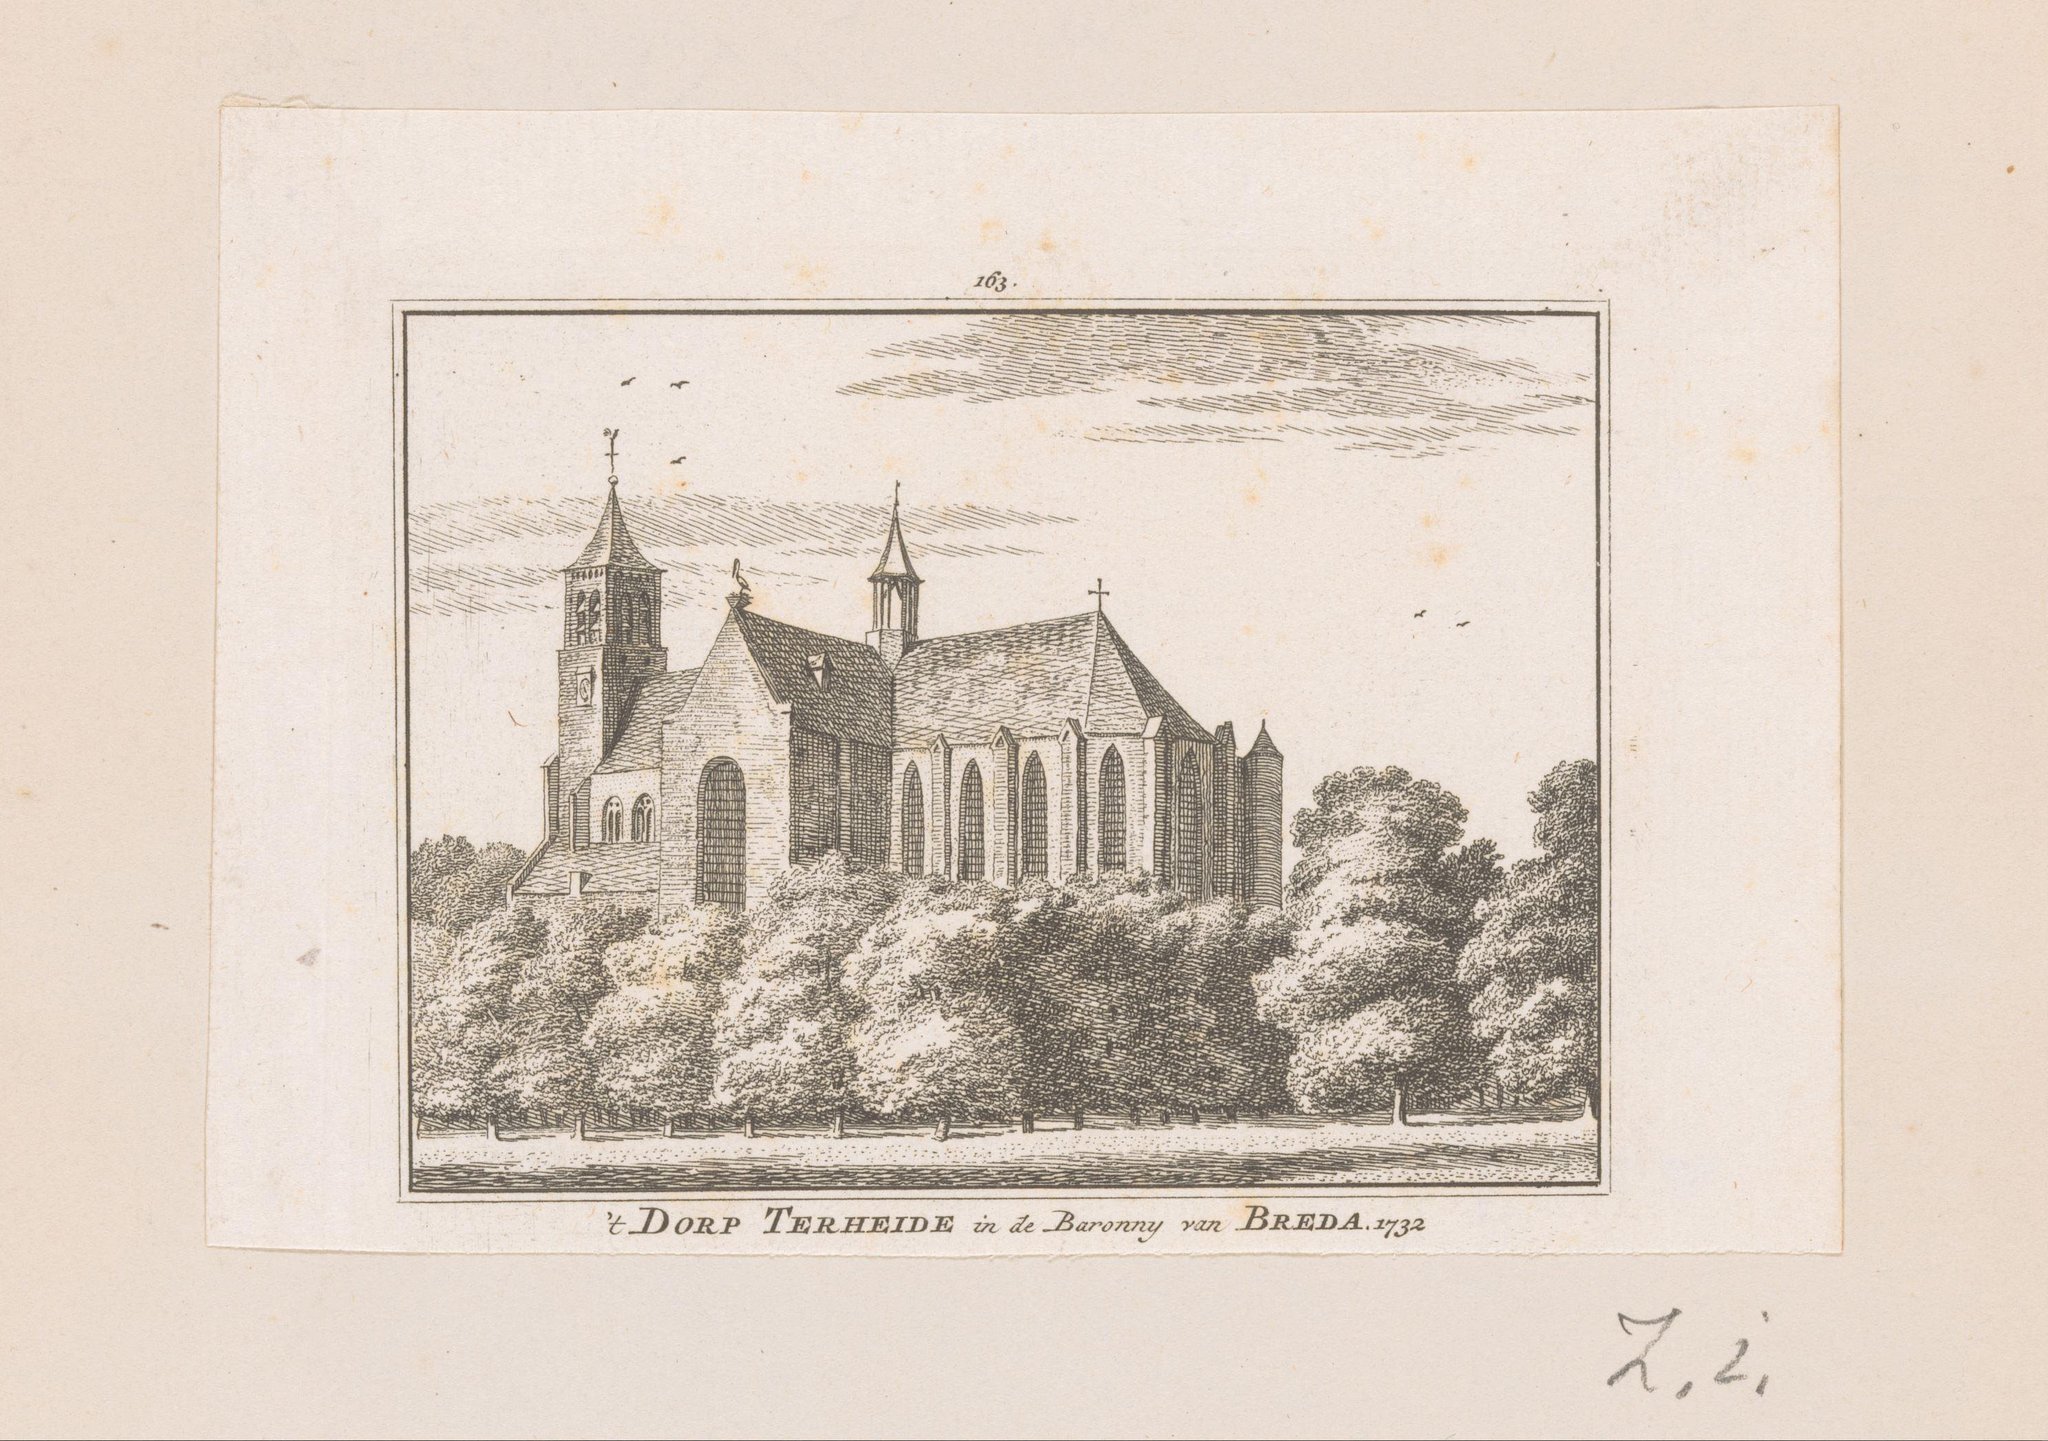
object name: book illustration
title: 't Dorp Terheide in de Baronny van Breda. 1732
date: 1746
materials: paper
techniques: engraving, etching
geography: amsterdam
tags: church (exterior)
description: Prent uit: Spilman, Hendrik. Het verheerlykt Nederland, of kabinet van hedendaagsche gezigten. 9 dln. Amsterdam: Isaac Tirion, 1745-1774, dl. 2 (1746).